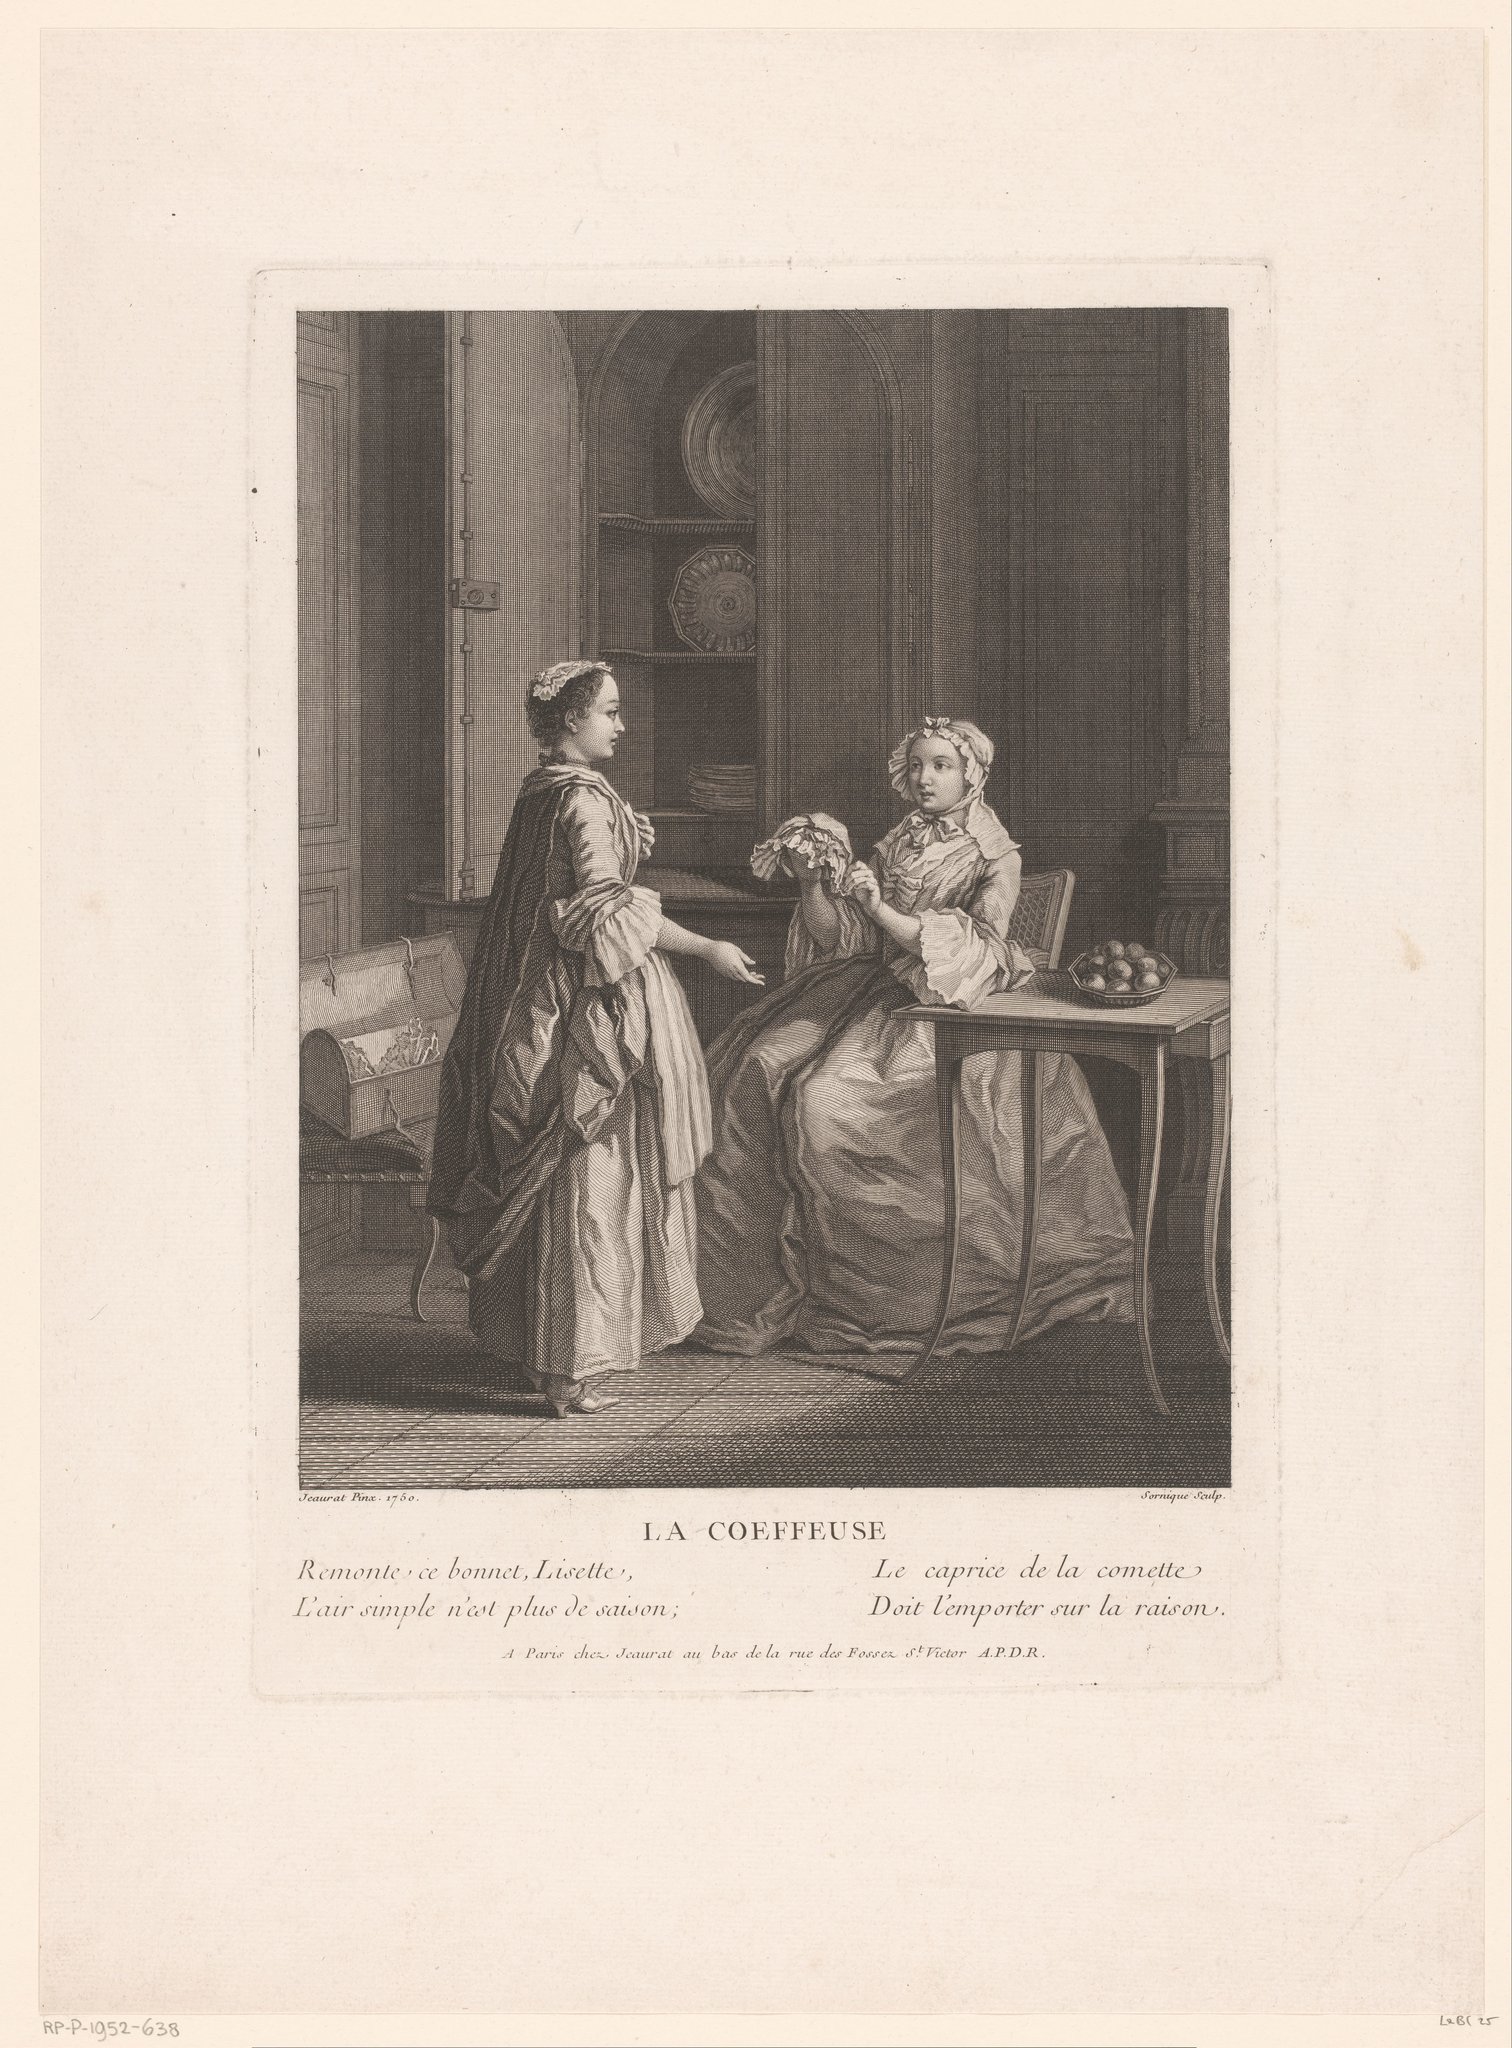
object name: print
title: Interieur met twee elegante dames die nieuwe mutsen bekijken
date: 1718-1756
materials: paper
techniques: engraving, etching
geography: paris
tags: dress, gown: morning dress (+ women's clothes), wandering or travelling merchant - bb - women engaged in trade and commerce, head-gear (bonnet) (+ women's clothes), dress, gown (+ women's clothes)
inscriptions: collector's mark: Lugt 2760, collector's mark: Lugt 2228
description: In een vertrek een zittende vrouw in huisjapon en muts op het hoofd. Op haar hand bekijkt ze een muts die haar is aangereikt door de staande vrouw tegenover haar die mutsen verkoopt. Rechts, op een bank staat haar kist met koopwaar. Met onderschrift over de mode in de mutsen.